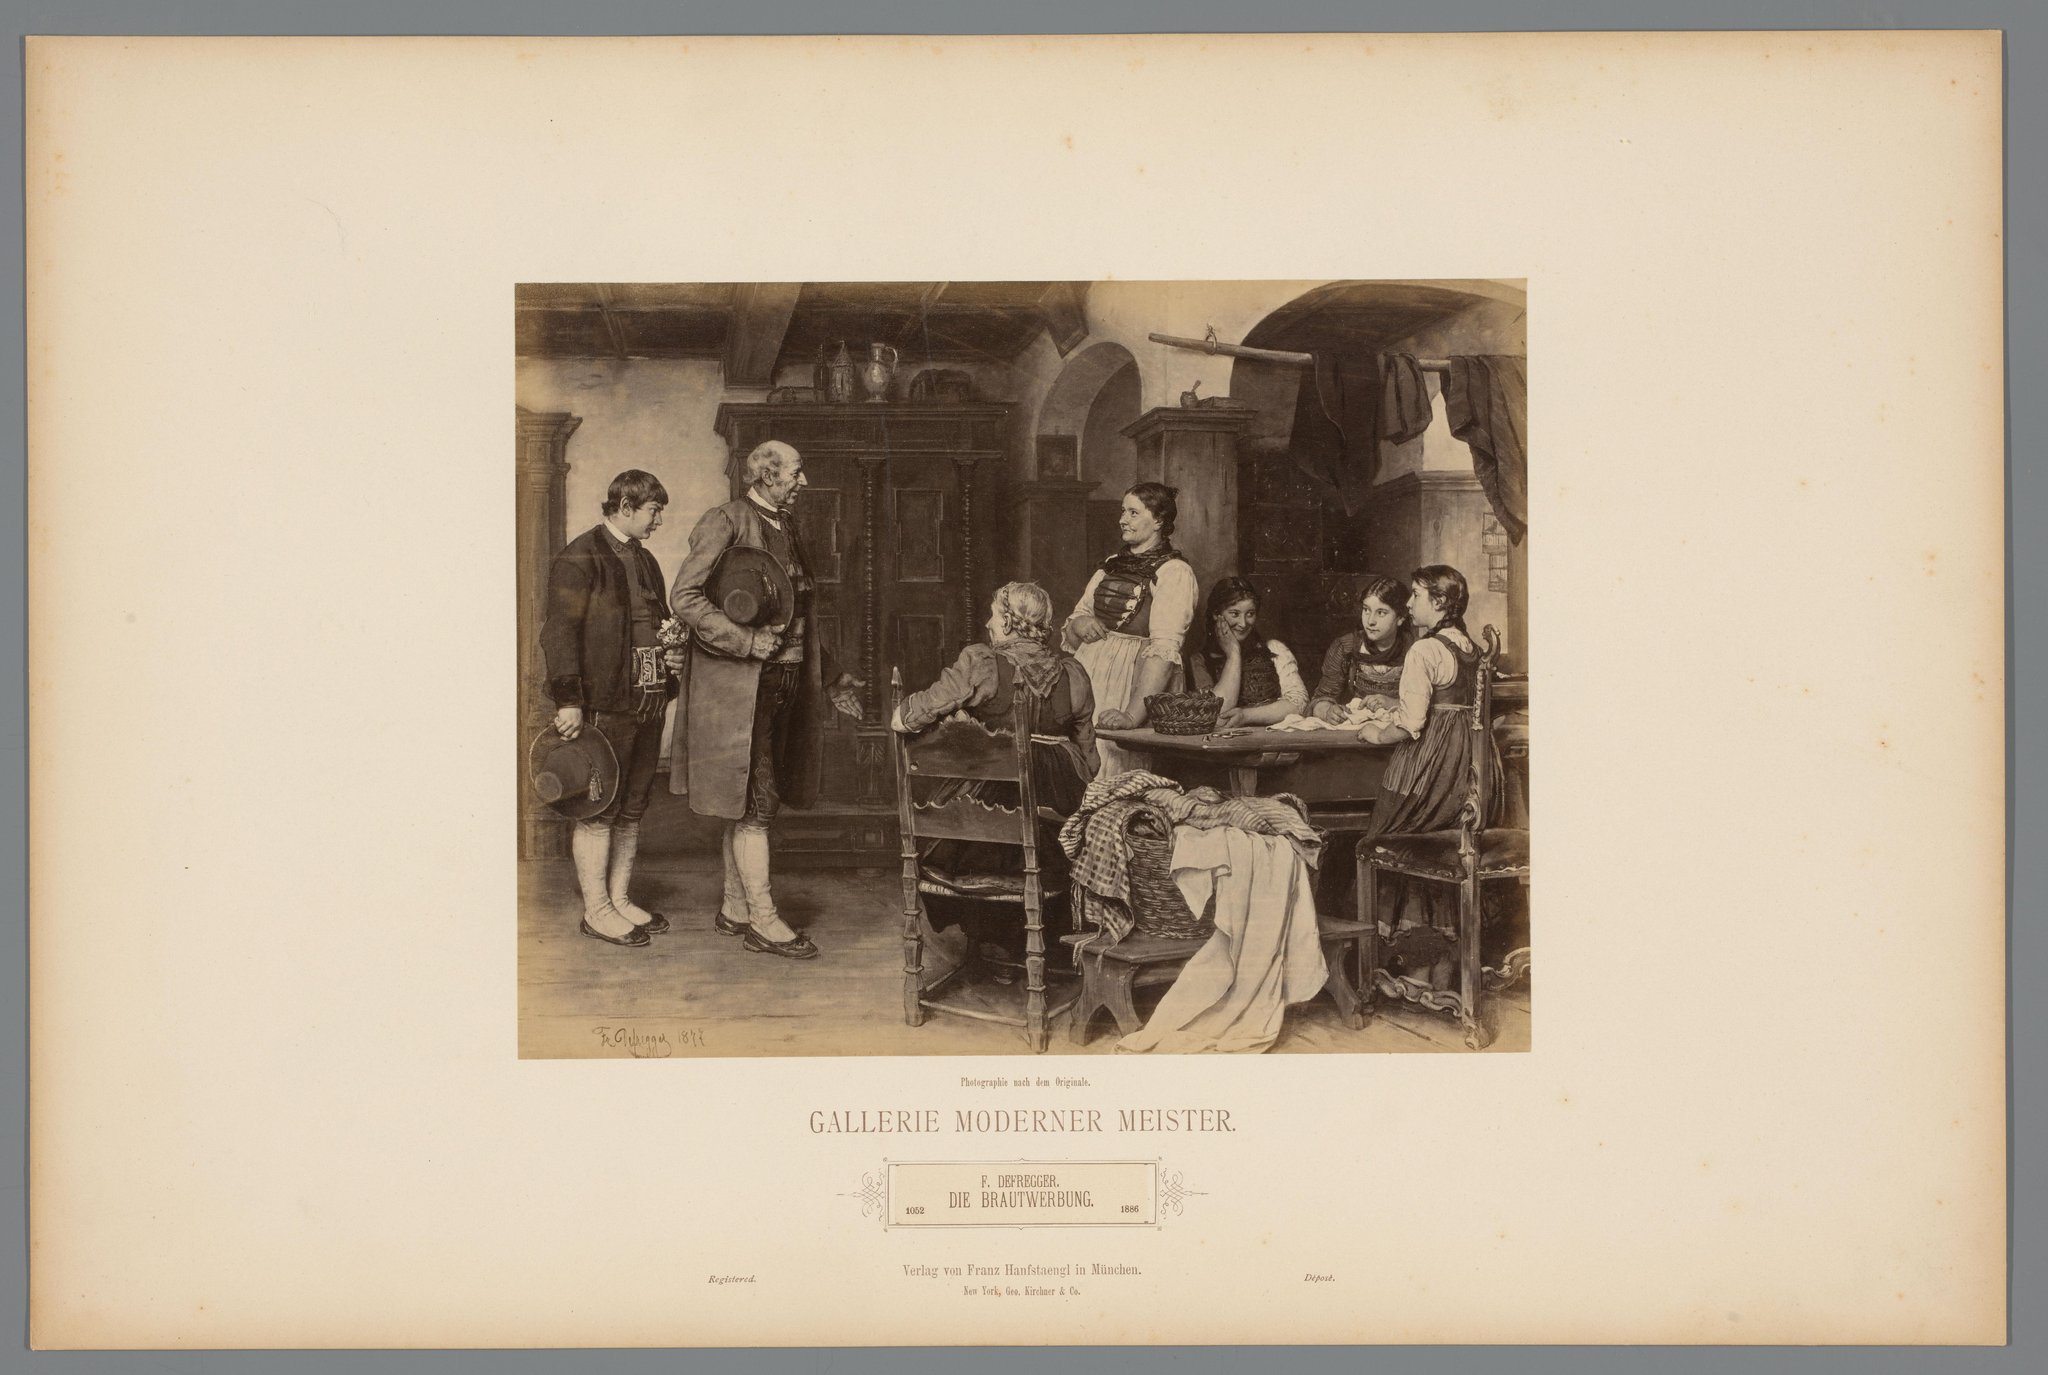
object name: photograph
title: Die Brautwerbung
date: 1886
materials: cardboard, photographic support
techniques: albumen print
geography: new york city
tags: courting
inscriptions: inscription: ‘Registered. - Déposé.’, inscription: ‘F. DEGREFFER/ DIE BRAUTWERBUNG./ 1052 - 1886’, inscription: ‘Photographie nach dem Originale.’